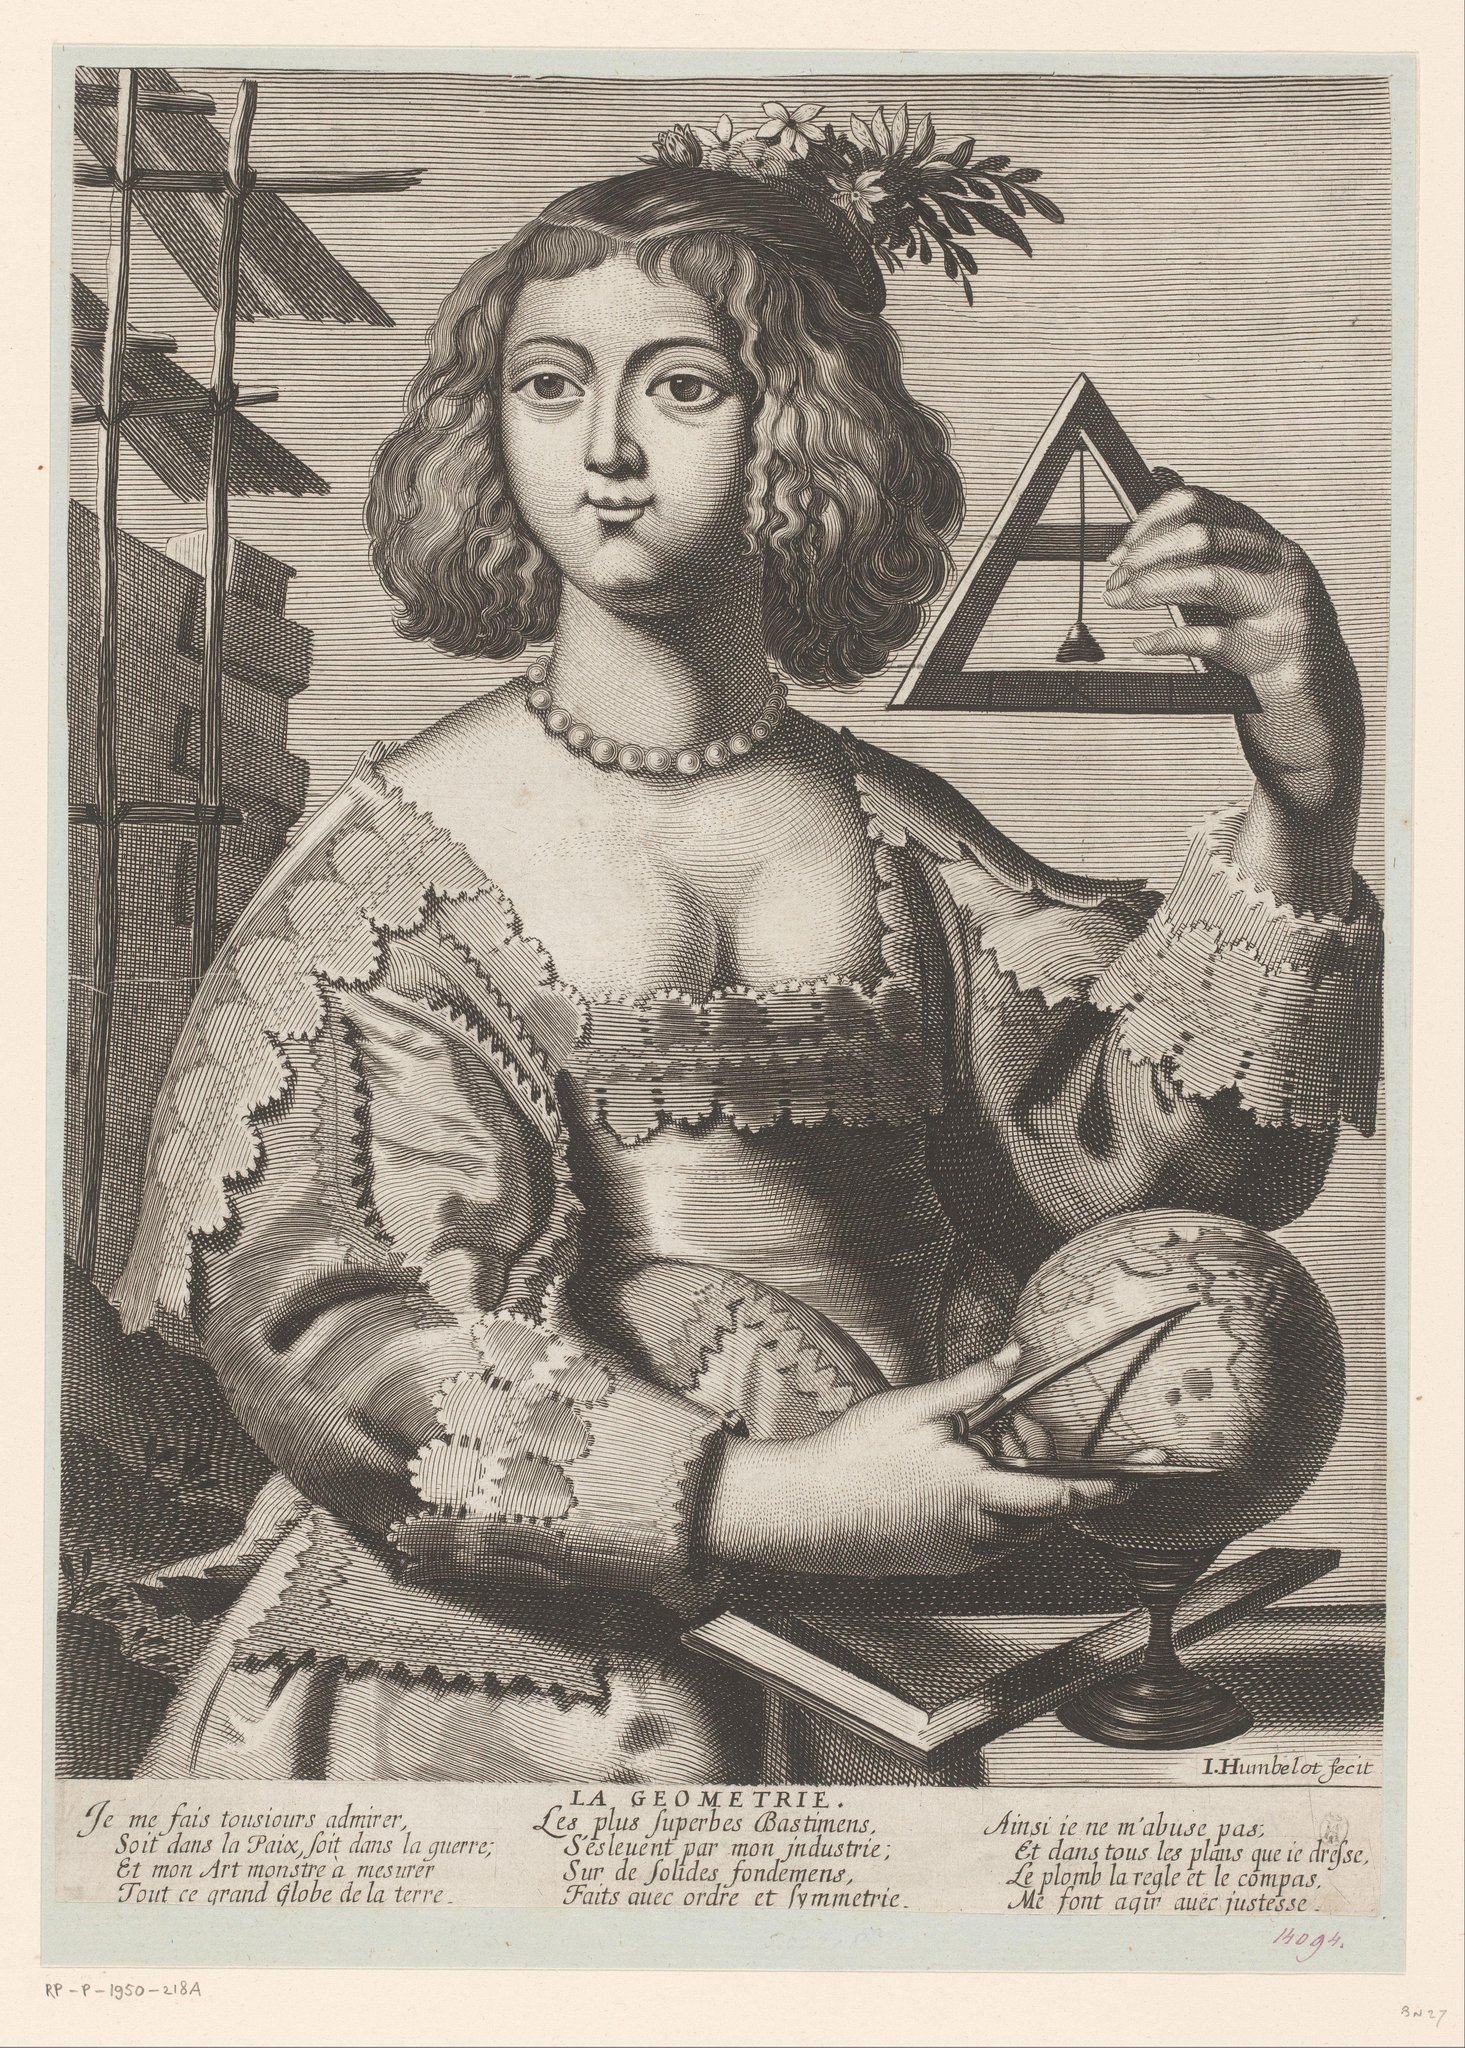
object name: print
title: Geometria (Geometrie)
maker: jean baptiste humbelot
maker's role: print maker, publisher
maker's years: 1600-1685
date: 1600-1685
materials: paper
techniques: engraving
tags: 'geometria' (~ quadrivium); 'geometria' (ripa)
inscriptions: number: ‘14094.’, collector's mark: Lugt 971, collector's mark: Lugt 2228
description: Maakt deel uit van een serie met personificaties van de vrije kunsten.